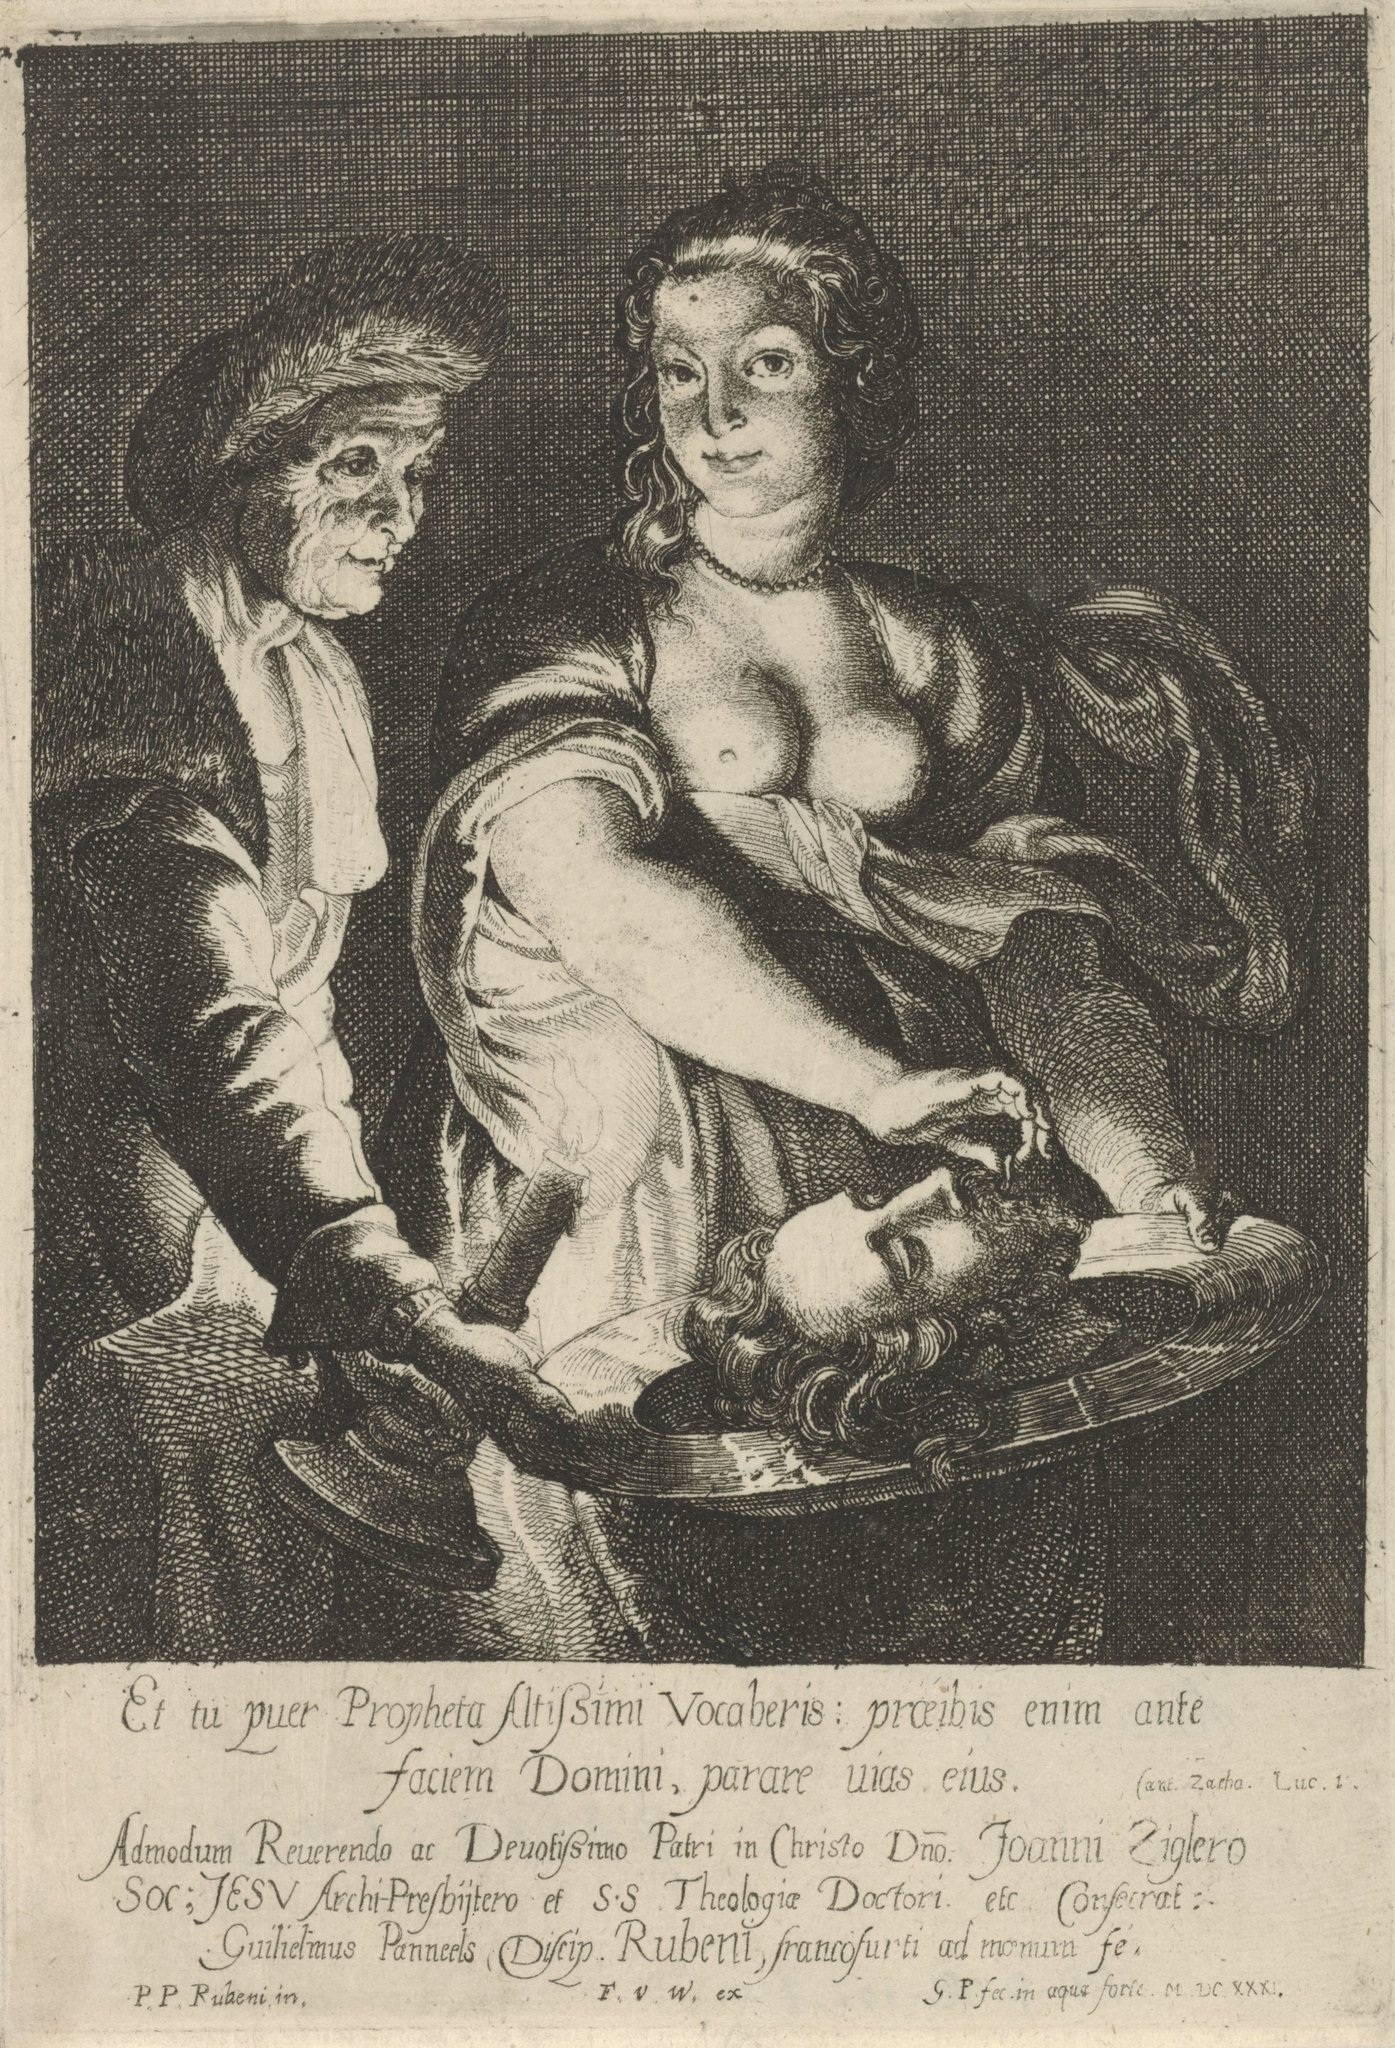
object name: print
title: Salome met het hoofd van Johannes de Doper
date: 1631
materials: paper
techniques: engraving, etching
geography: frankfurt am main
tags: salome gives the head of john the baptist to her mother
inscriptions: collector's mark: Lugt 2228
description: Salome geeft de schotel met het hoofd van Johannes de Doper aan haar moeder Herodias. In de marge een onderschrift in het Latijn.